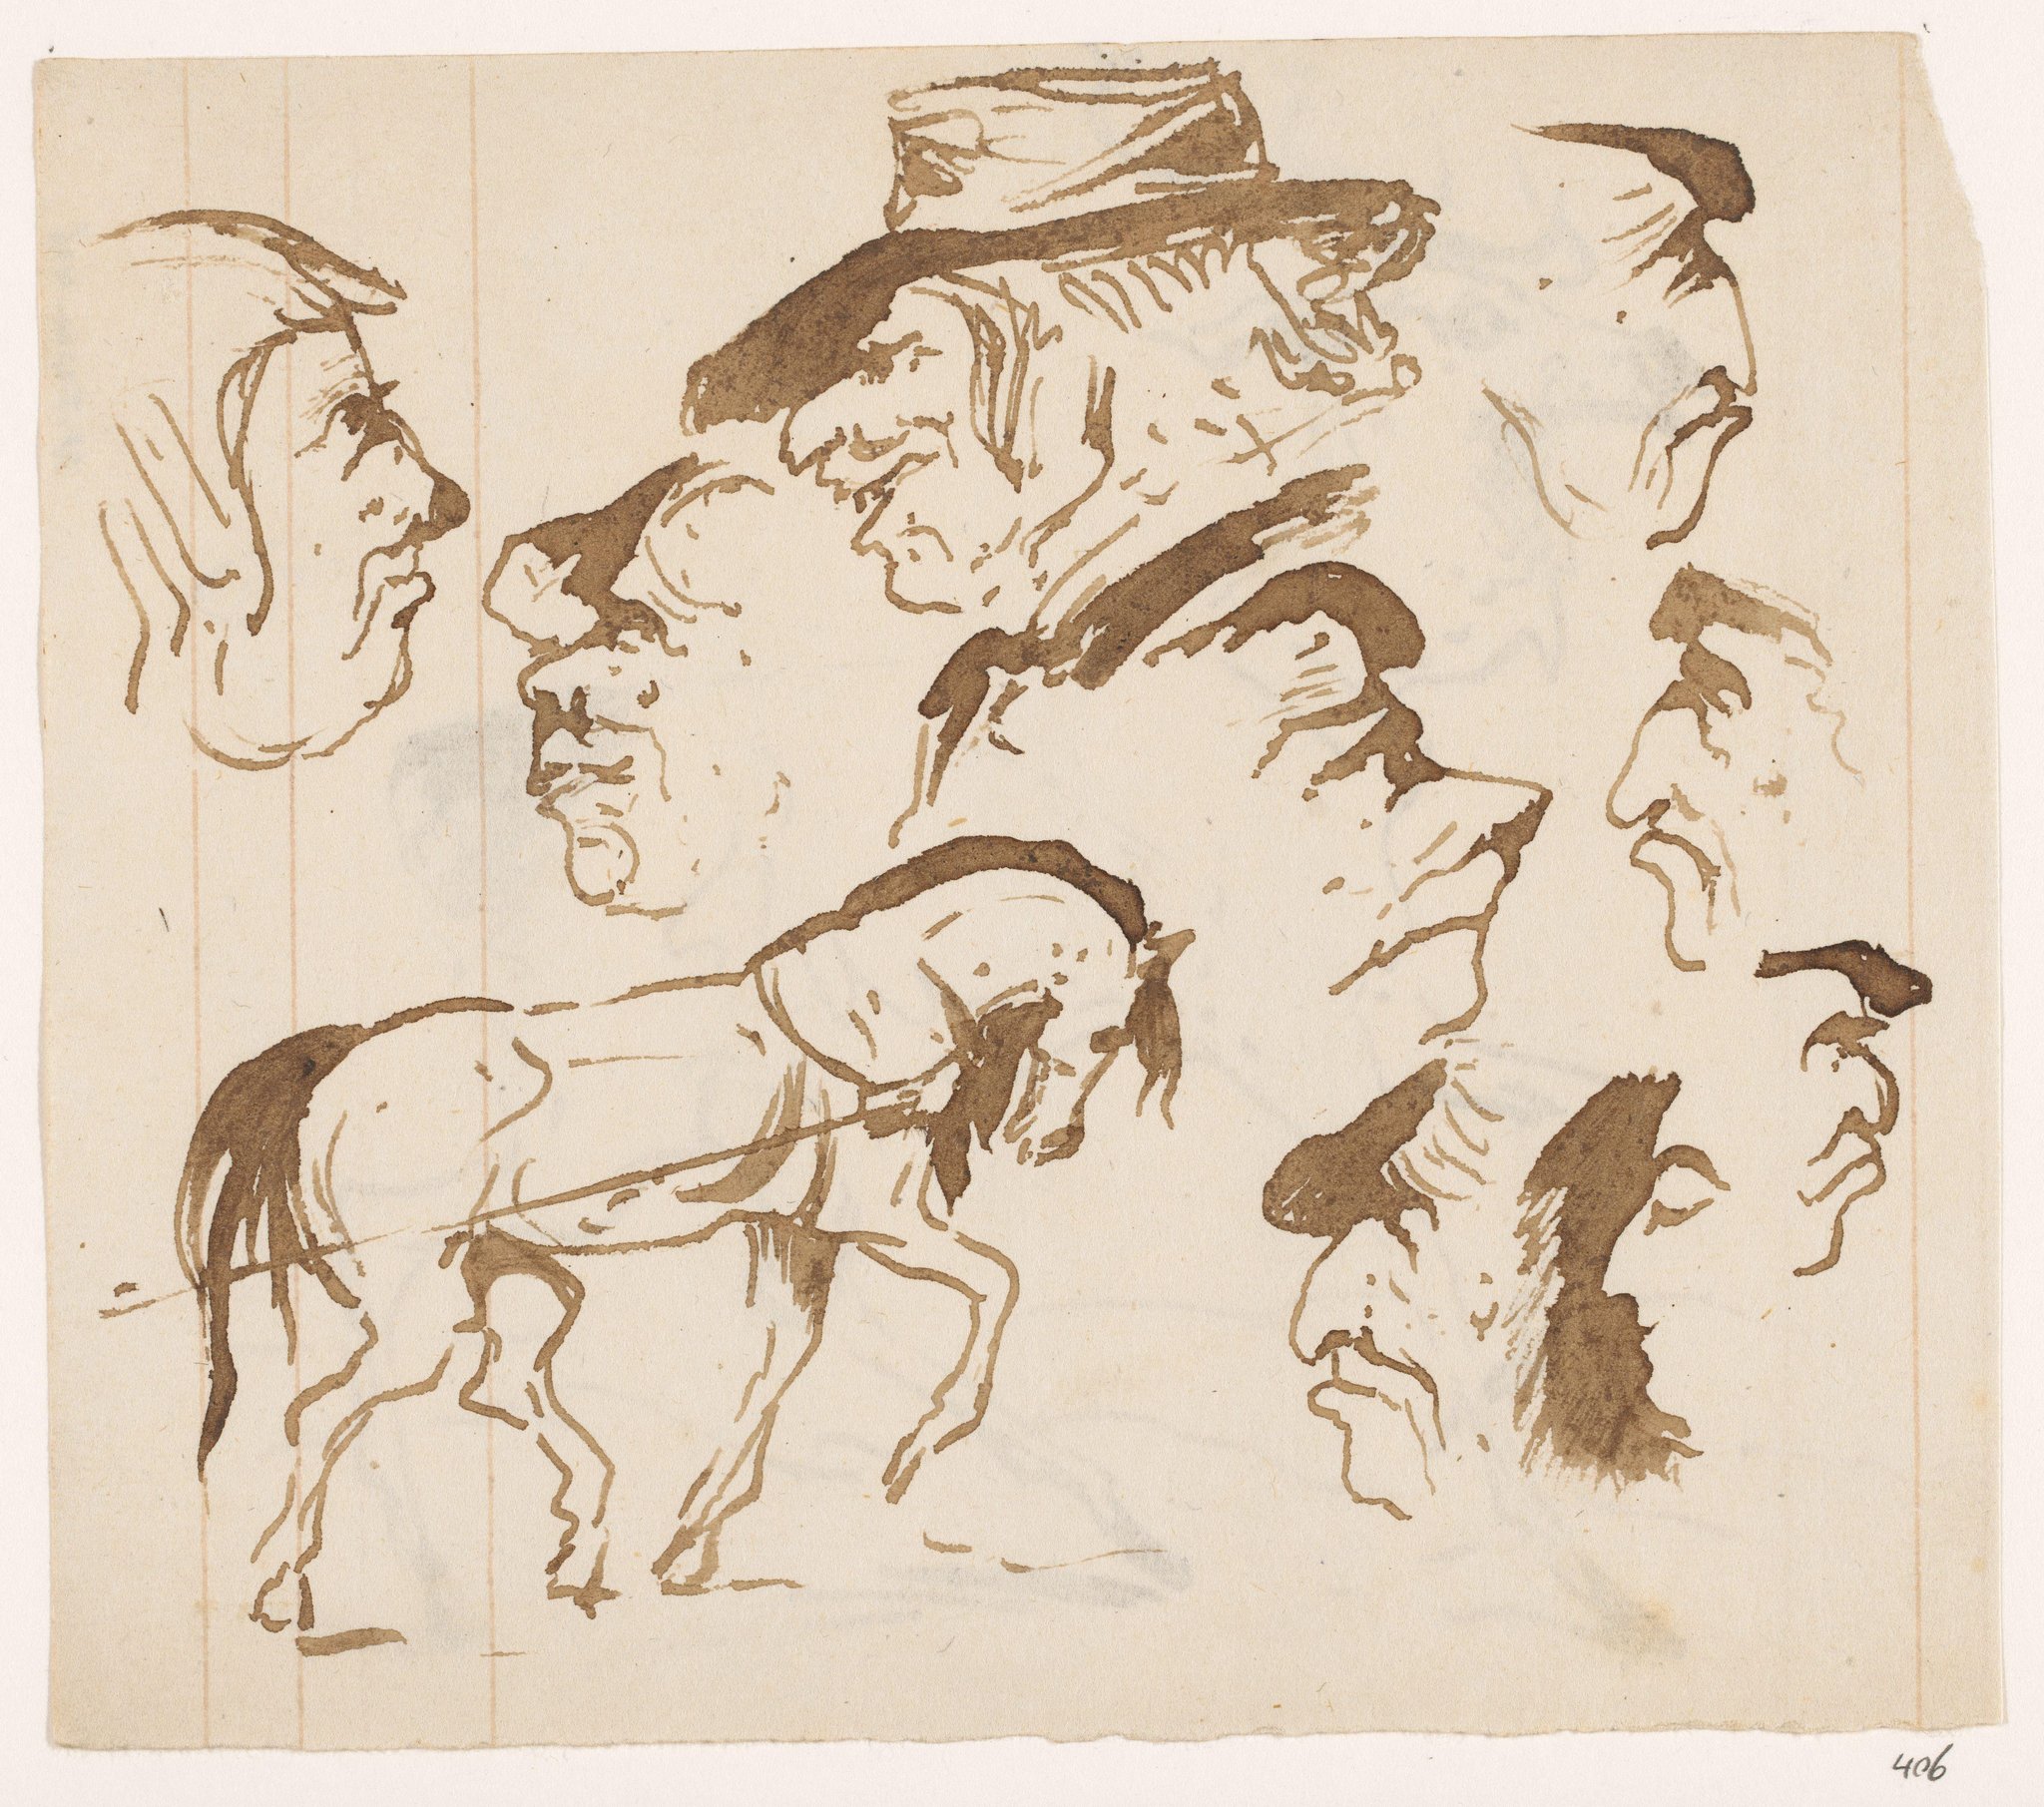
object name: drawing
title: Schetsblad met koppen en paard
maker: johannes tavenraat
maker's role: draughtsman, painter, print maker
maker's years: 1809-1881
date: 1840-1880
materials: ink, paper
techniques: pen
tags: caricatures (human types), horse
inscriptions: collector's mark: Lugt 2228